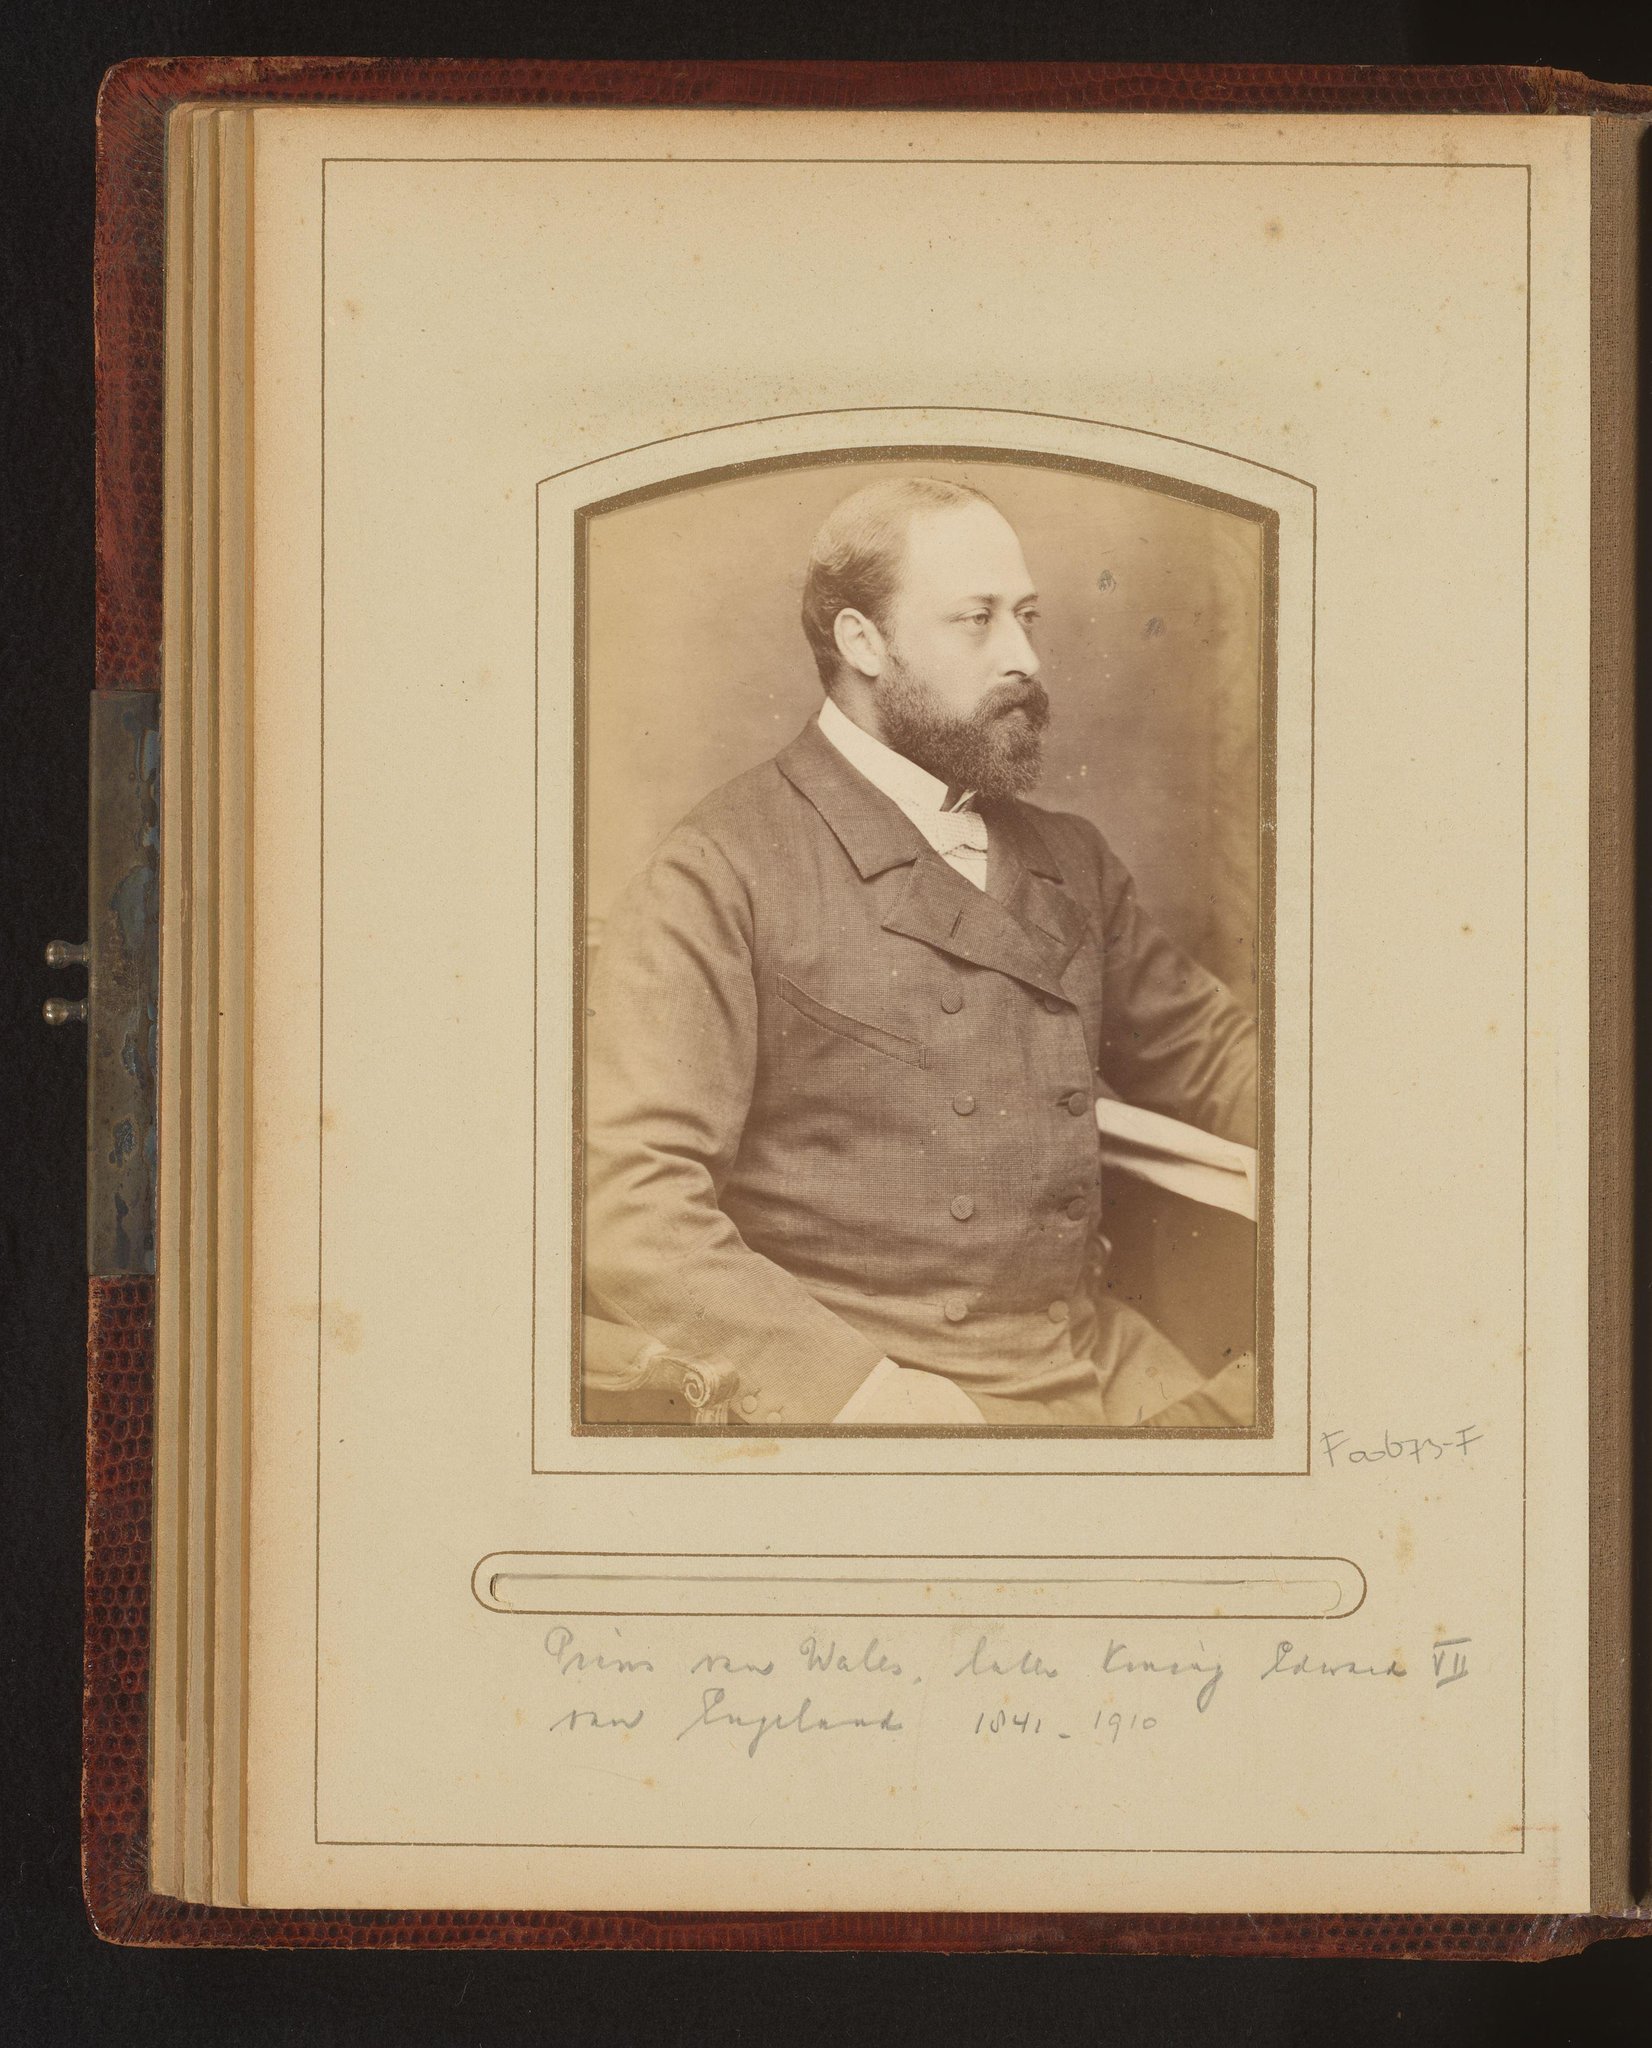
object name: photograph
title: Portret van Eduard VII, koning van het Verenigd Koninkrijk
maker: Anonymous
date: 1870-1890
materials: cardboard, photographic support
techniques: albumen print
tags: london, historical persons, king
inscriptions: annotation: ‘Prins van Wales, later koning Eduard VII van Engeland 1841 - 1910’, annotation: ‘Prince of Wales/ 22-1-'01: Eduard VII/ geb 9-11-41/ geh met Alexandra van Denemarken op 10-3-'63’